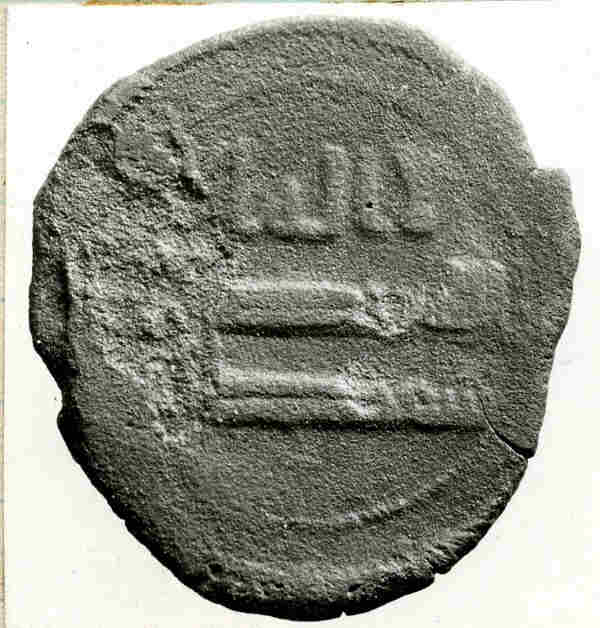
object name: coin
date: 718-814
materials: copper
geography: iran